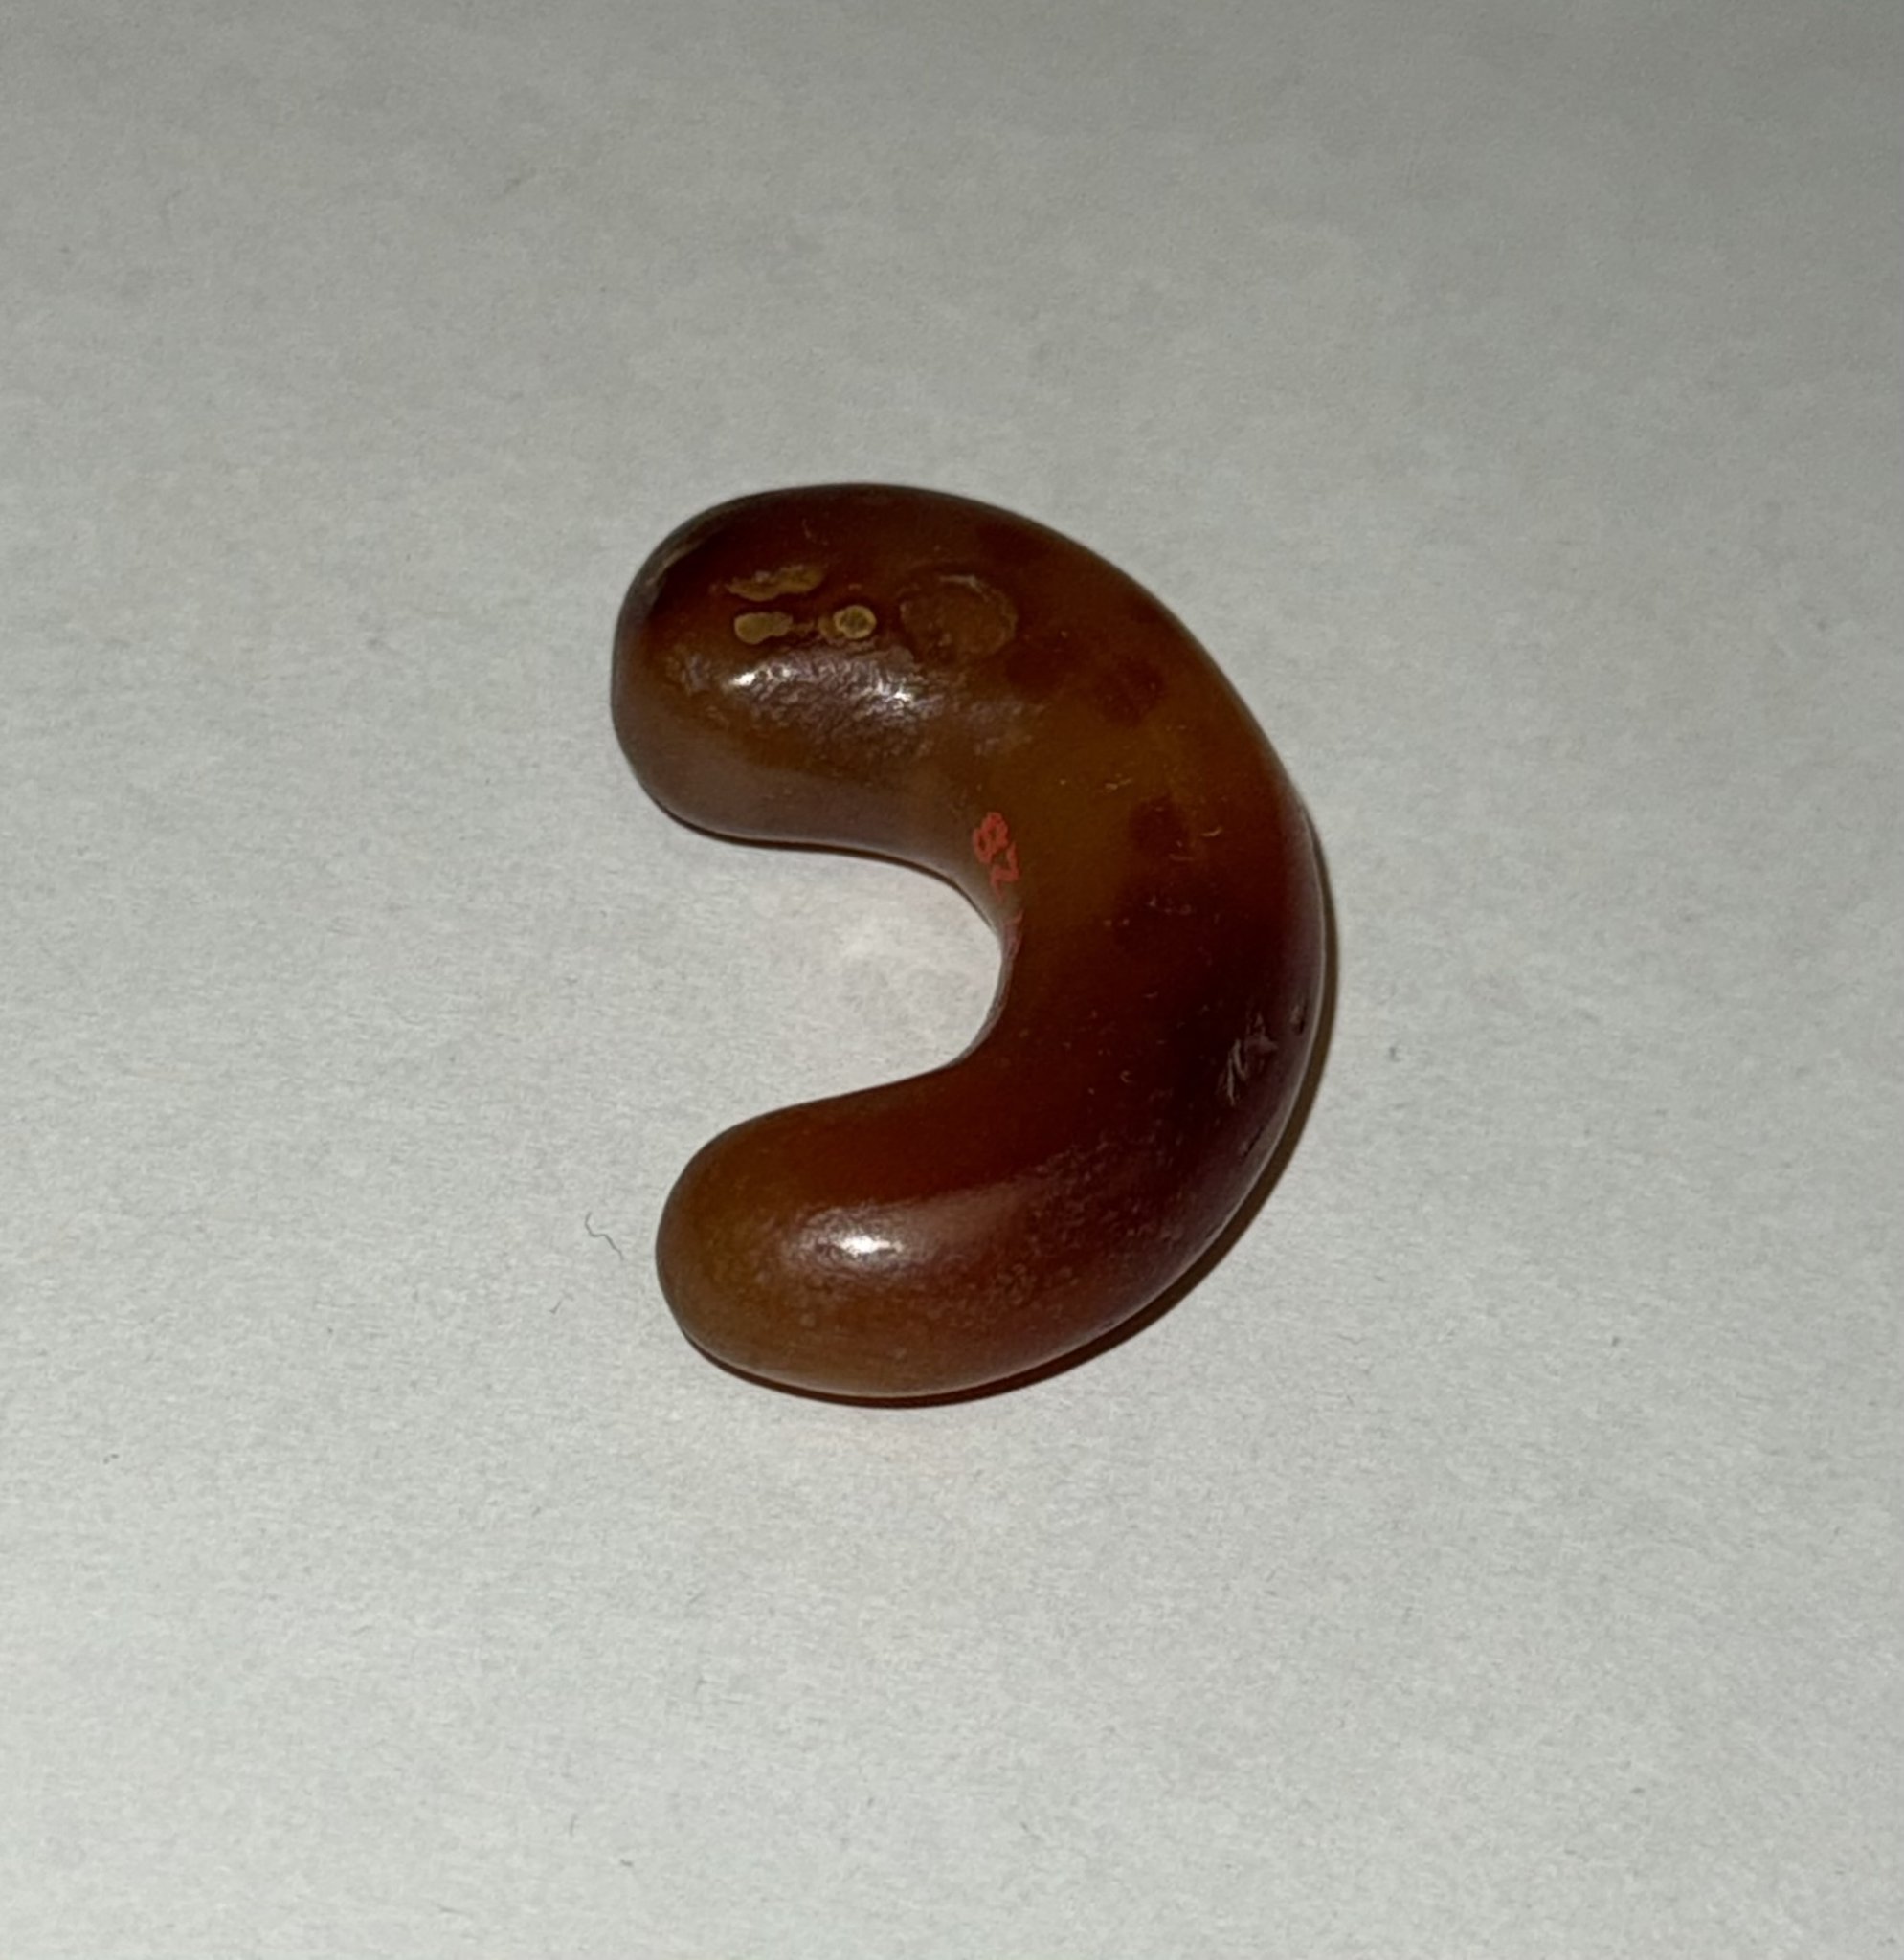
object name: jewel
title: Tiger Claw Jewel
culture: japanese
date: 601-700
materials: stone, jade, jasper